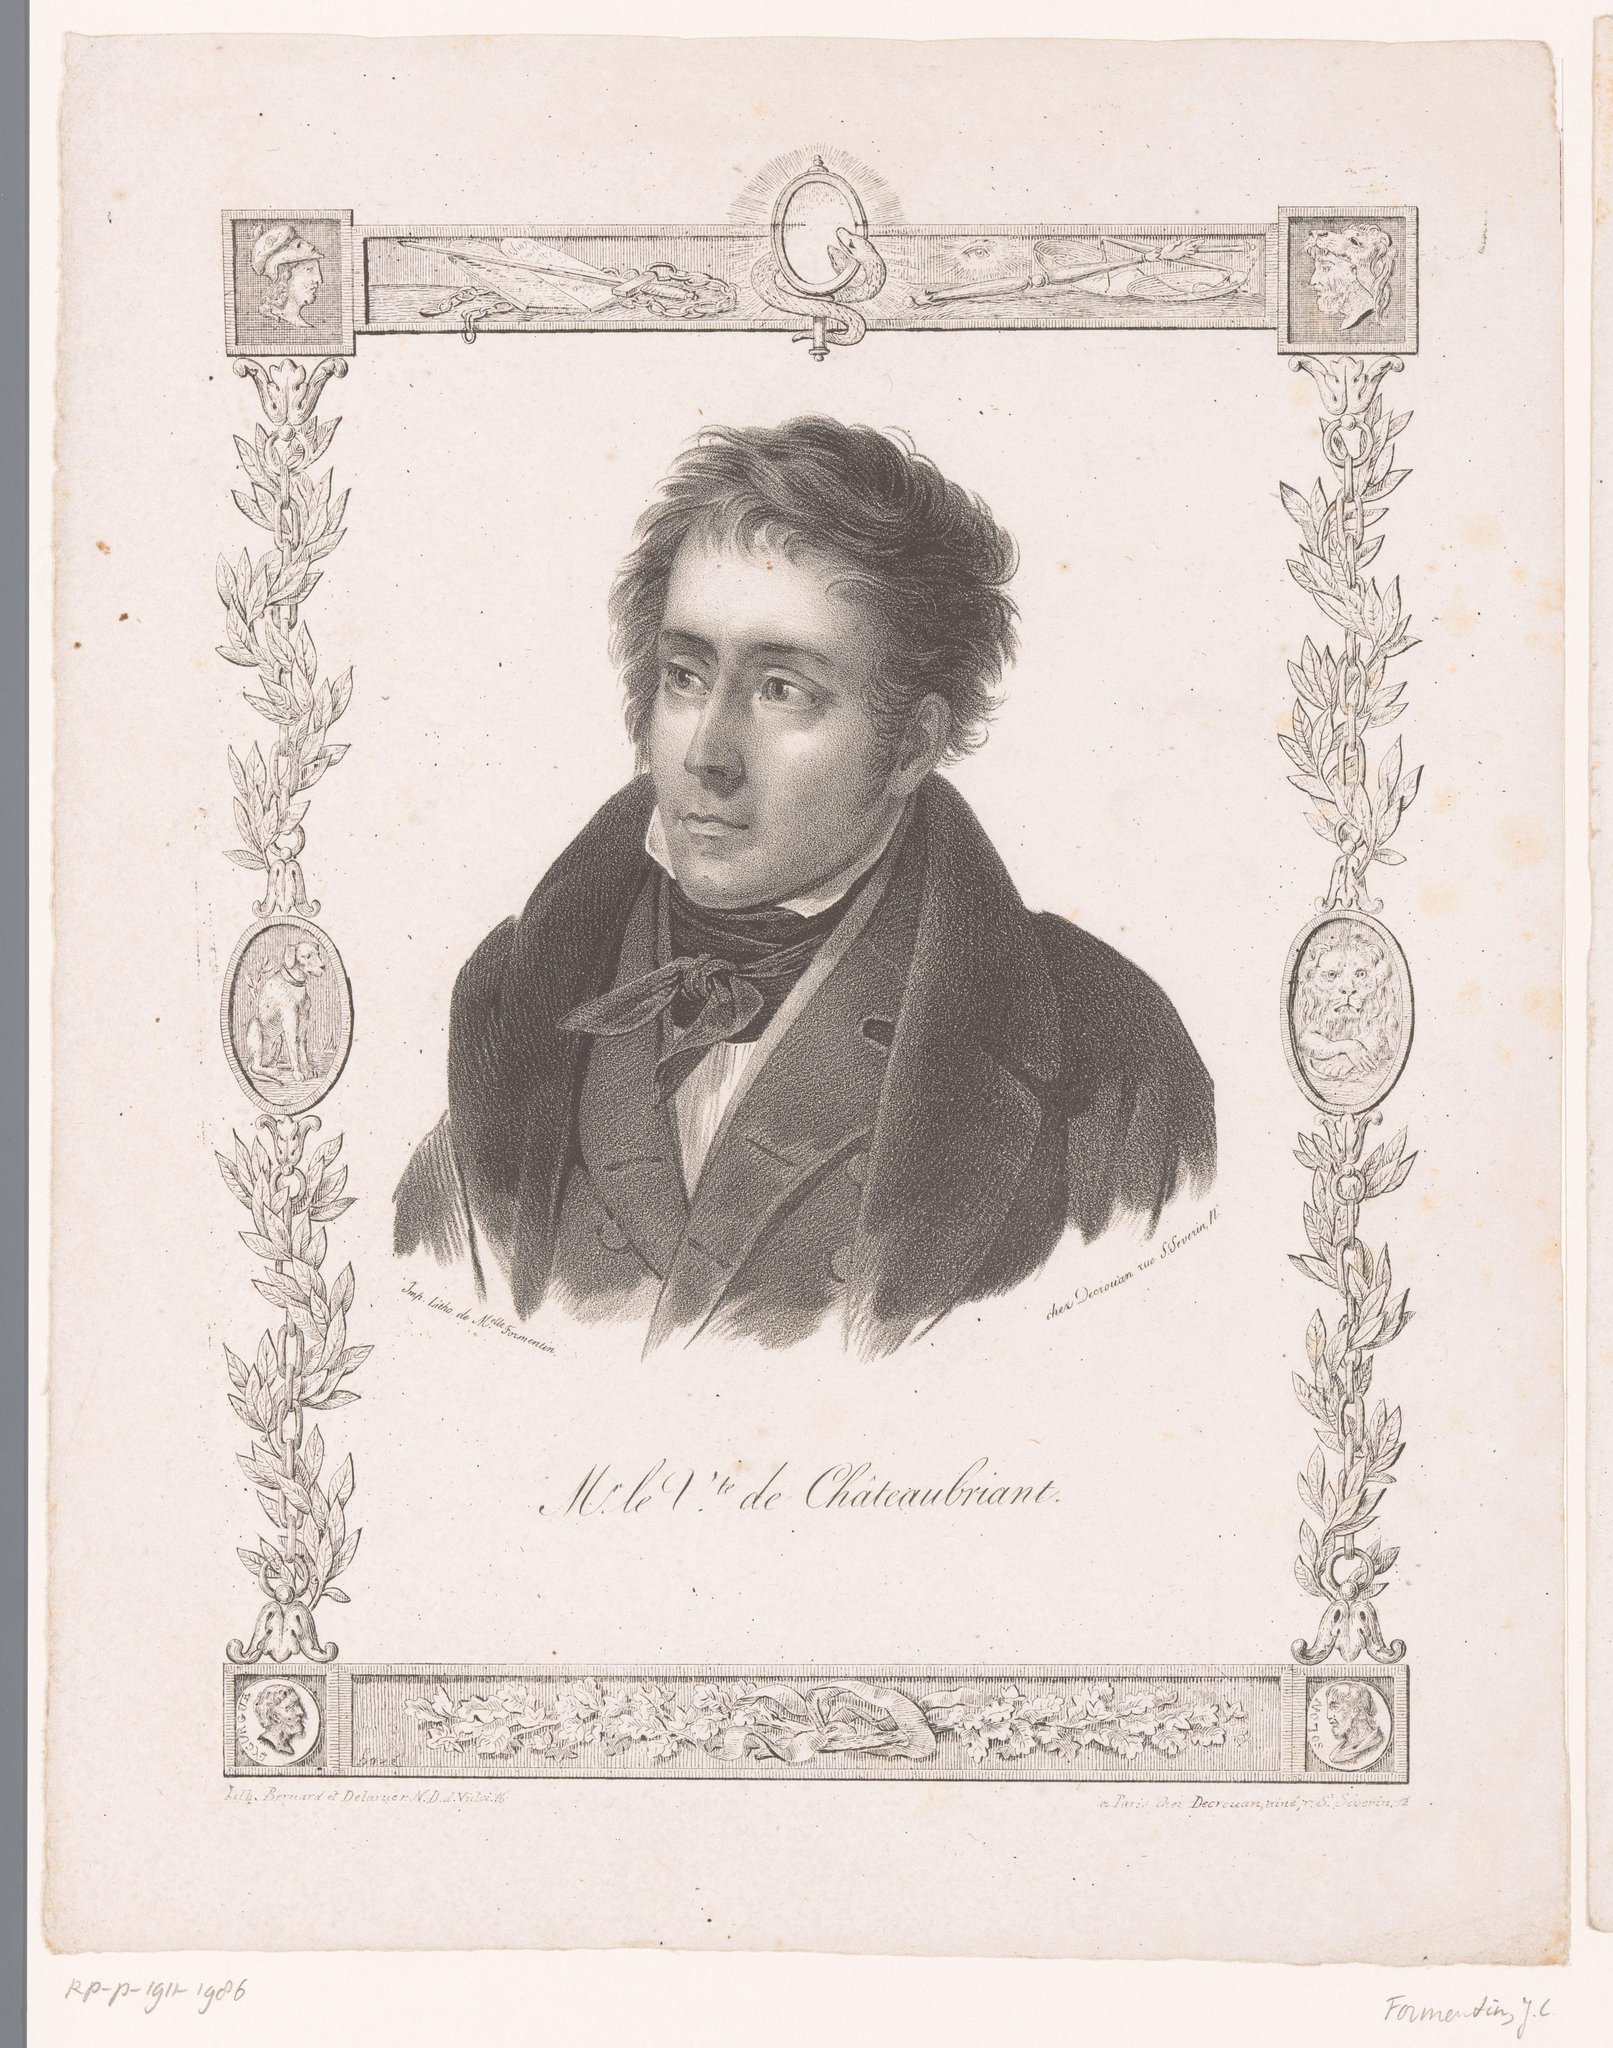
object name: print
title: M.r le V.te de Chateaubriant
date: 1826-1829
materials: paper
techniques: lithograph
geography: paris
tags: paris, politician, françois-rené de chateaubriand, historical persons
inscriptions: collector's mark: Lugt 2228a